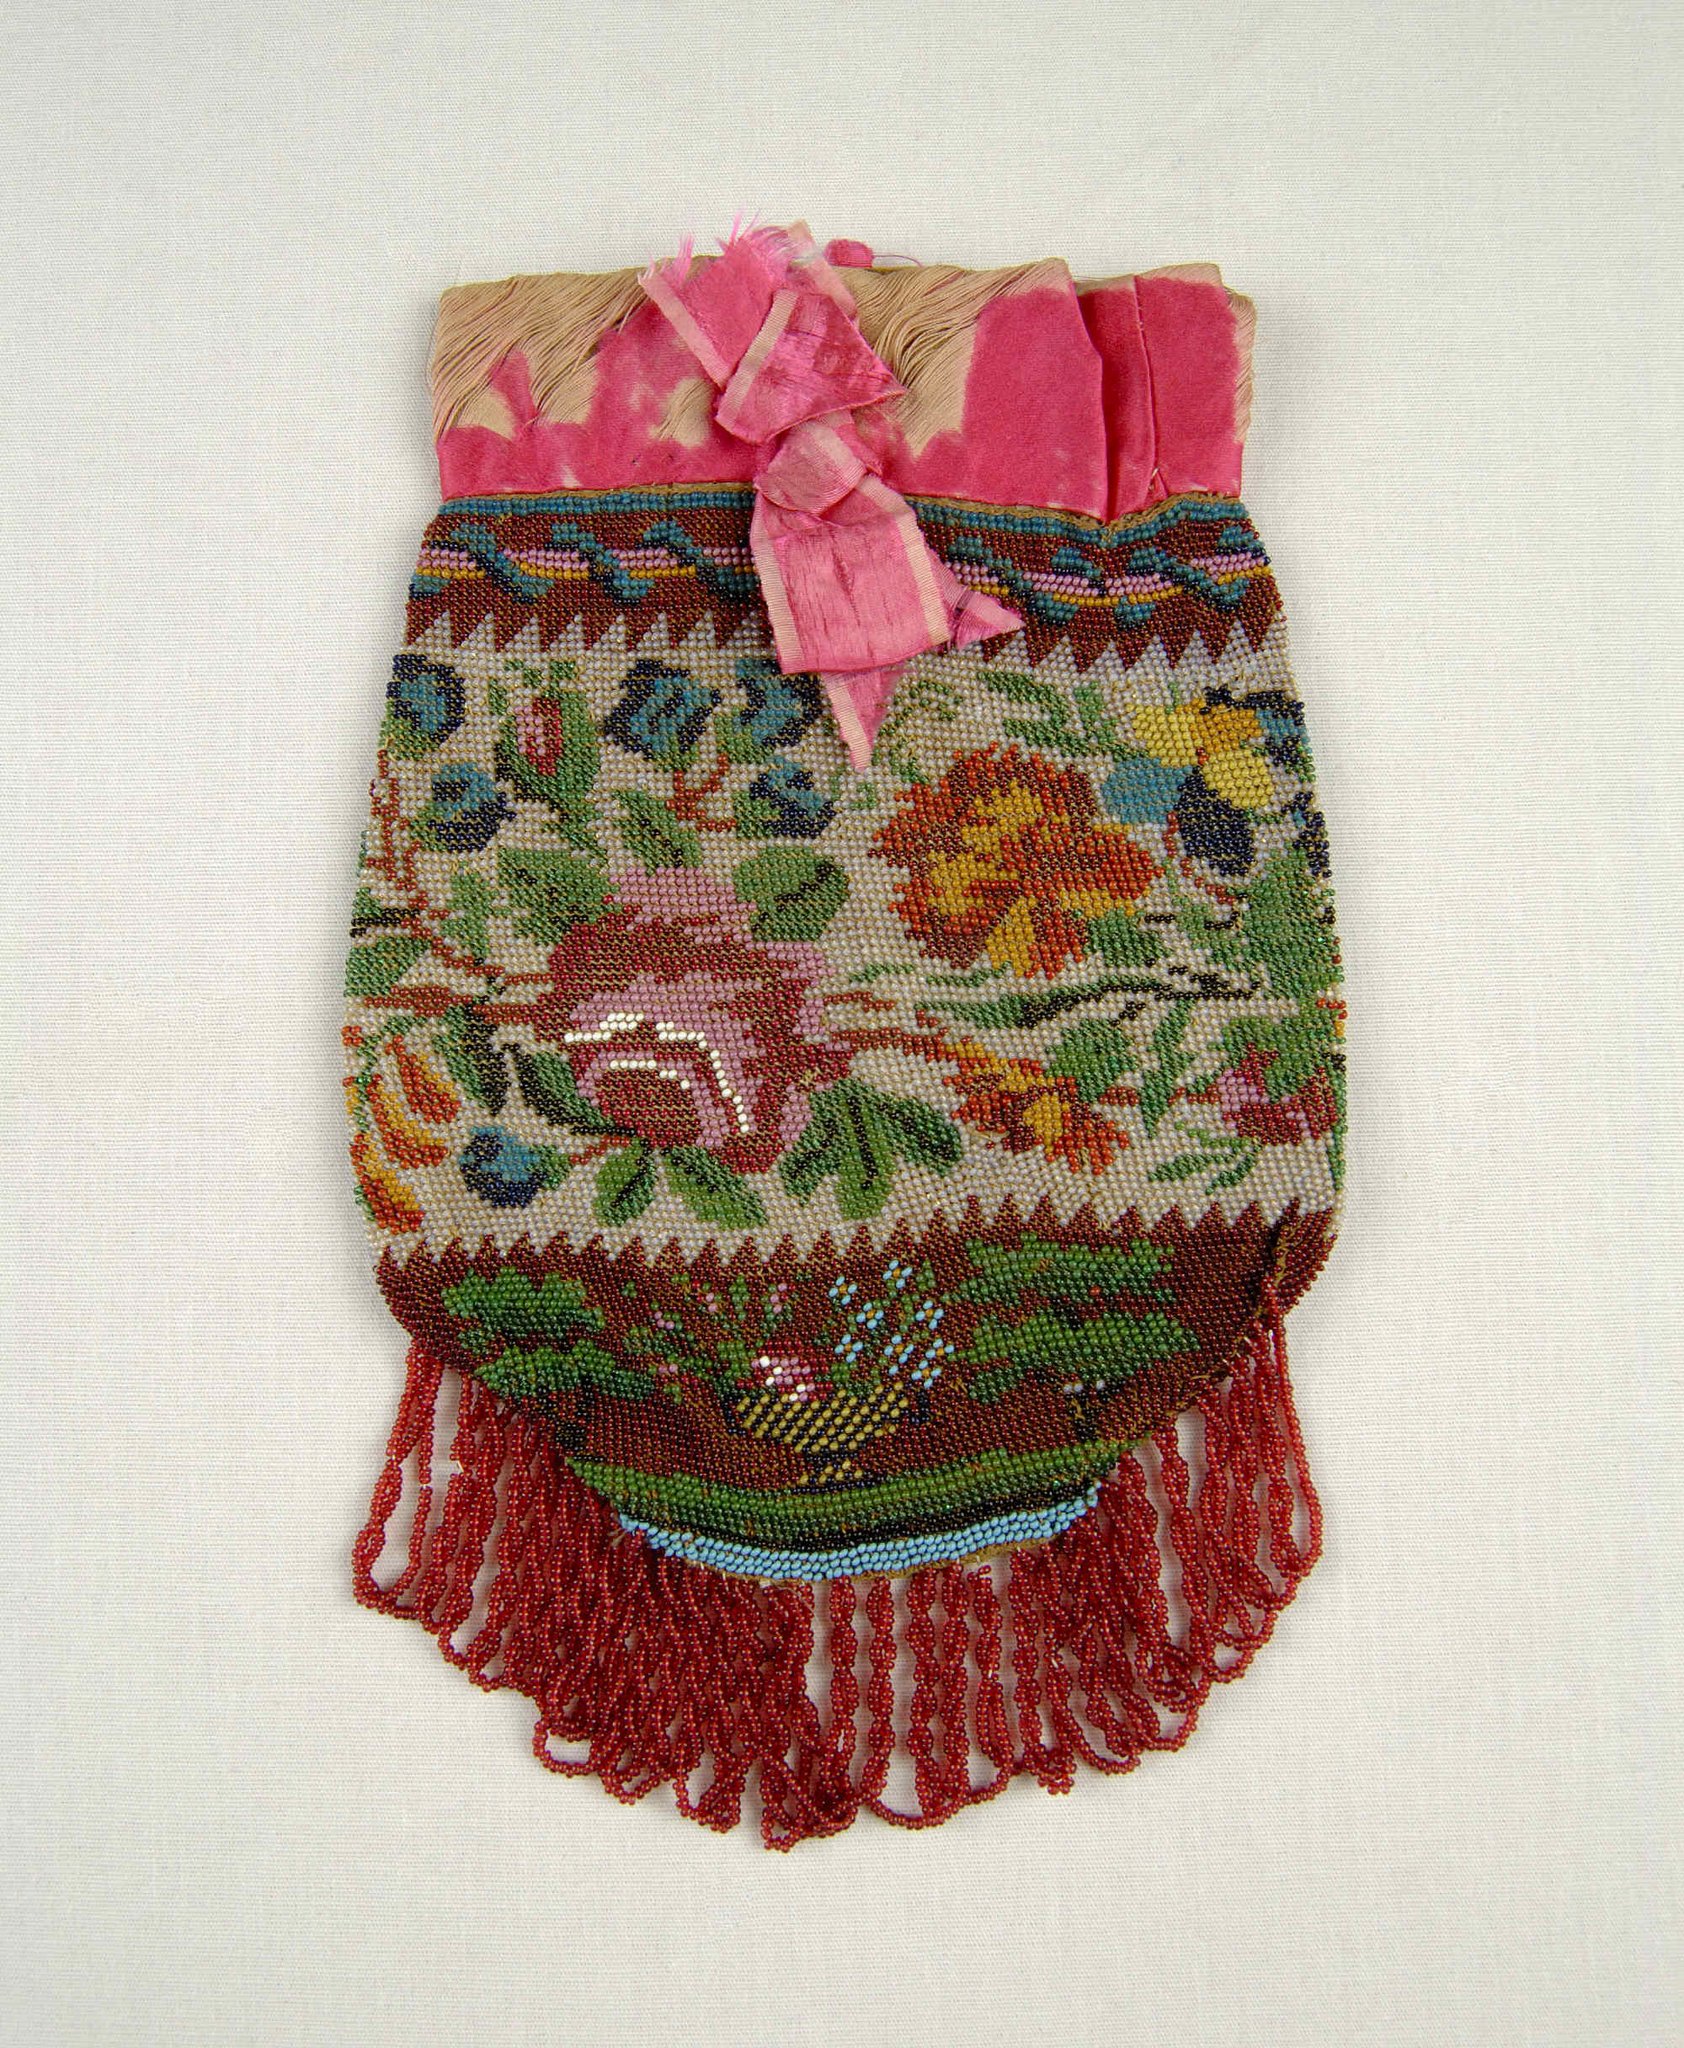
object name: pouch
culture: american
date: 1840-1860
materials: cotton, glass, linen, silk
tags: flowers